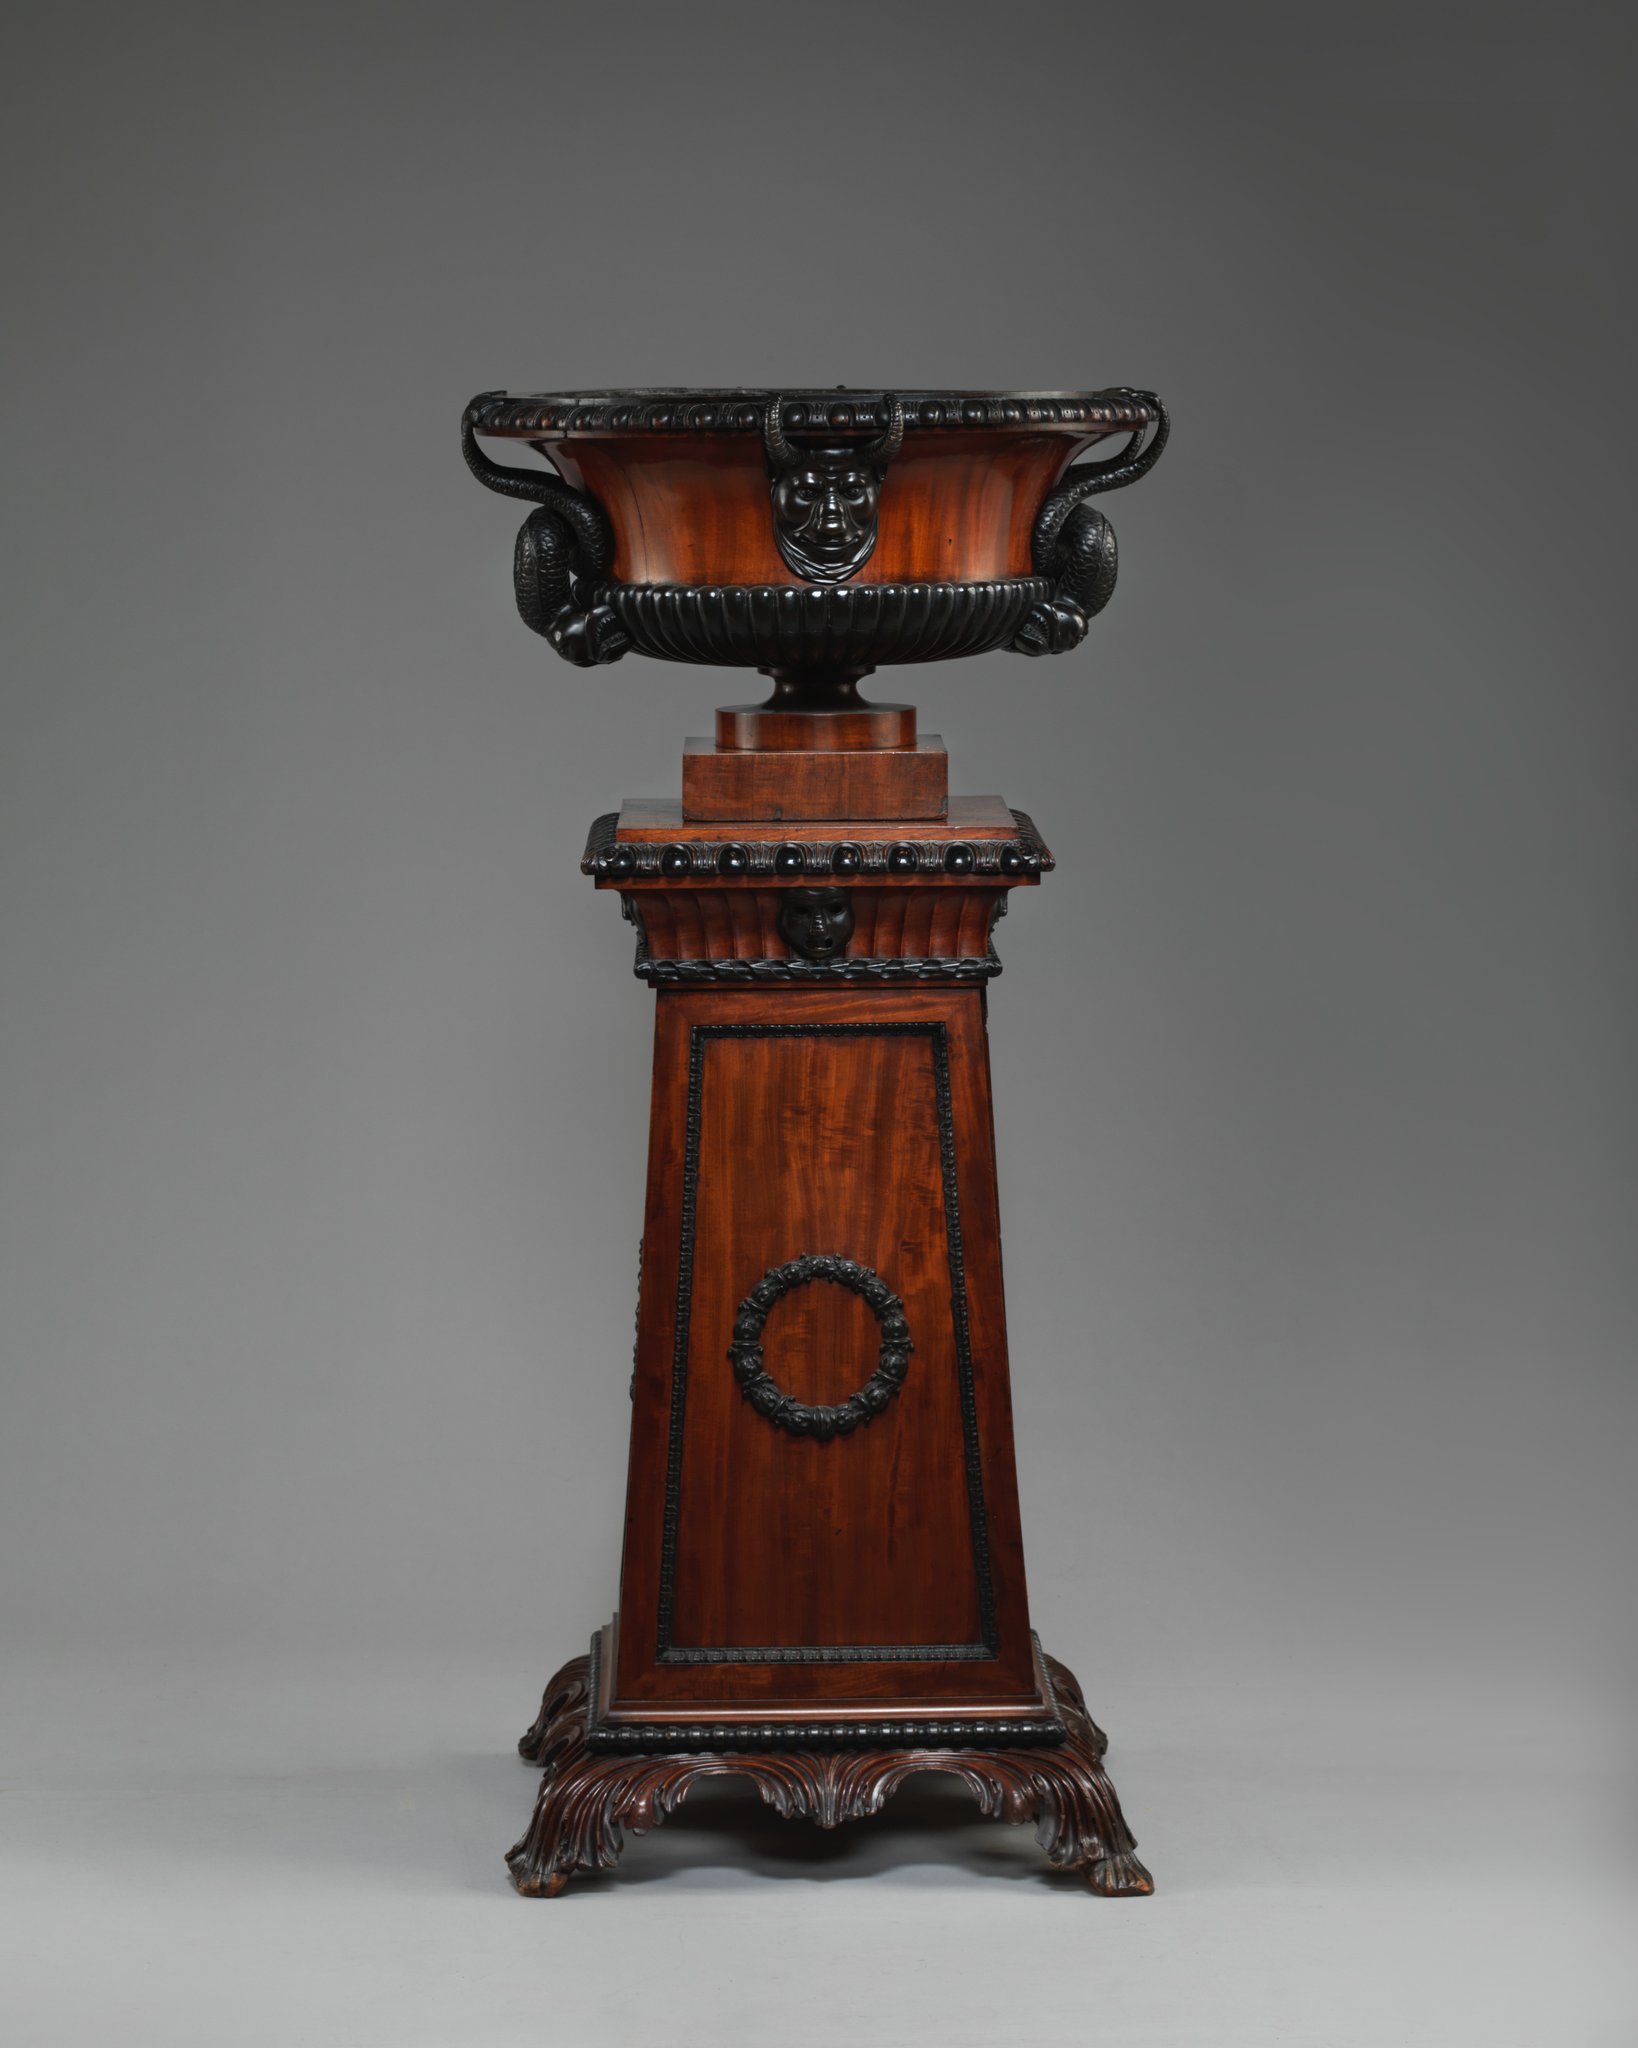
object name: wine cistern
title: Wine cistern (urn and pedestal) (one of a pair)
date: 1820-1830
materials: bronze, wood